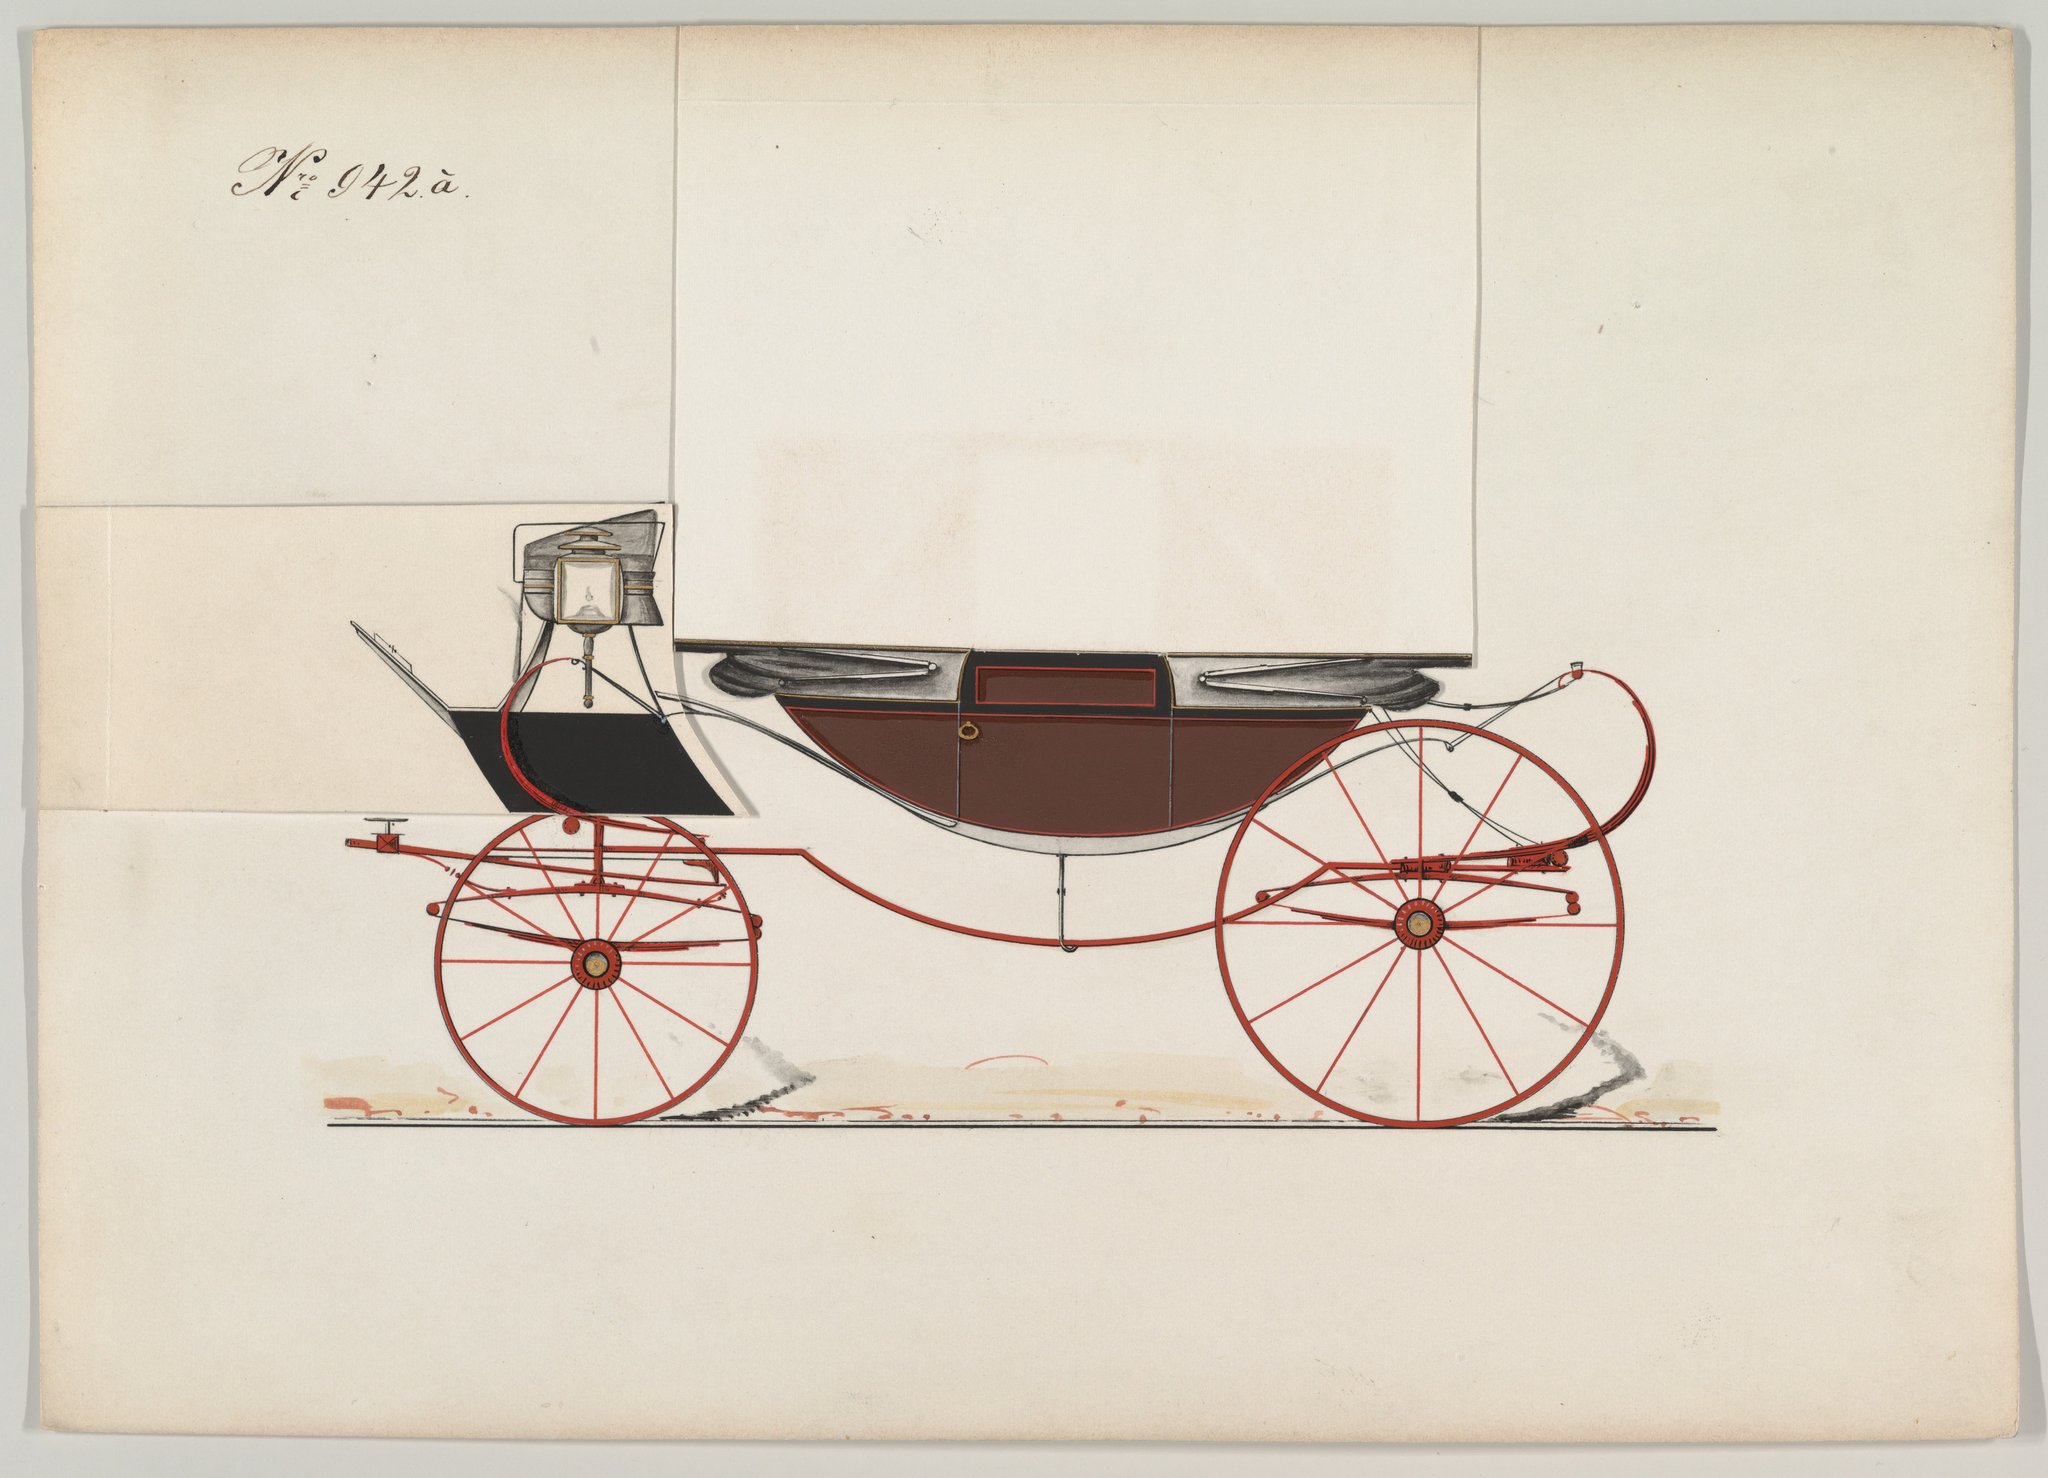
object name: drawing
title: Landau #942a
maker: brewster & co.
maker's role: manufacturer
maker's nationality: american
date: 1850-1860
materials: gouache, gum arabic, ink, watercolor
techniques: pen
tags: carriages